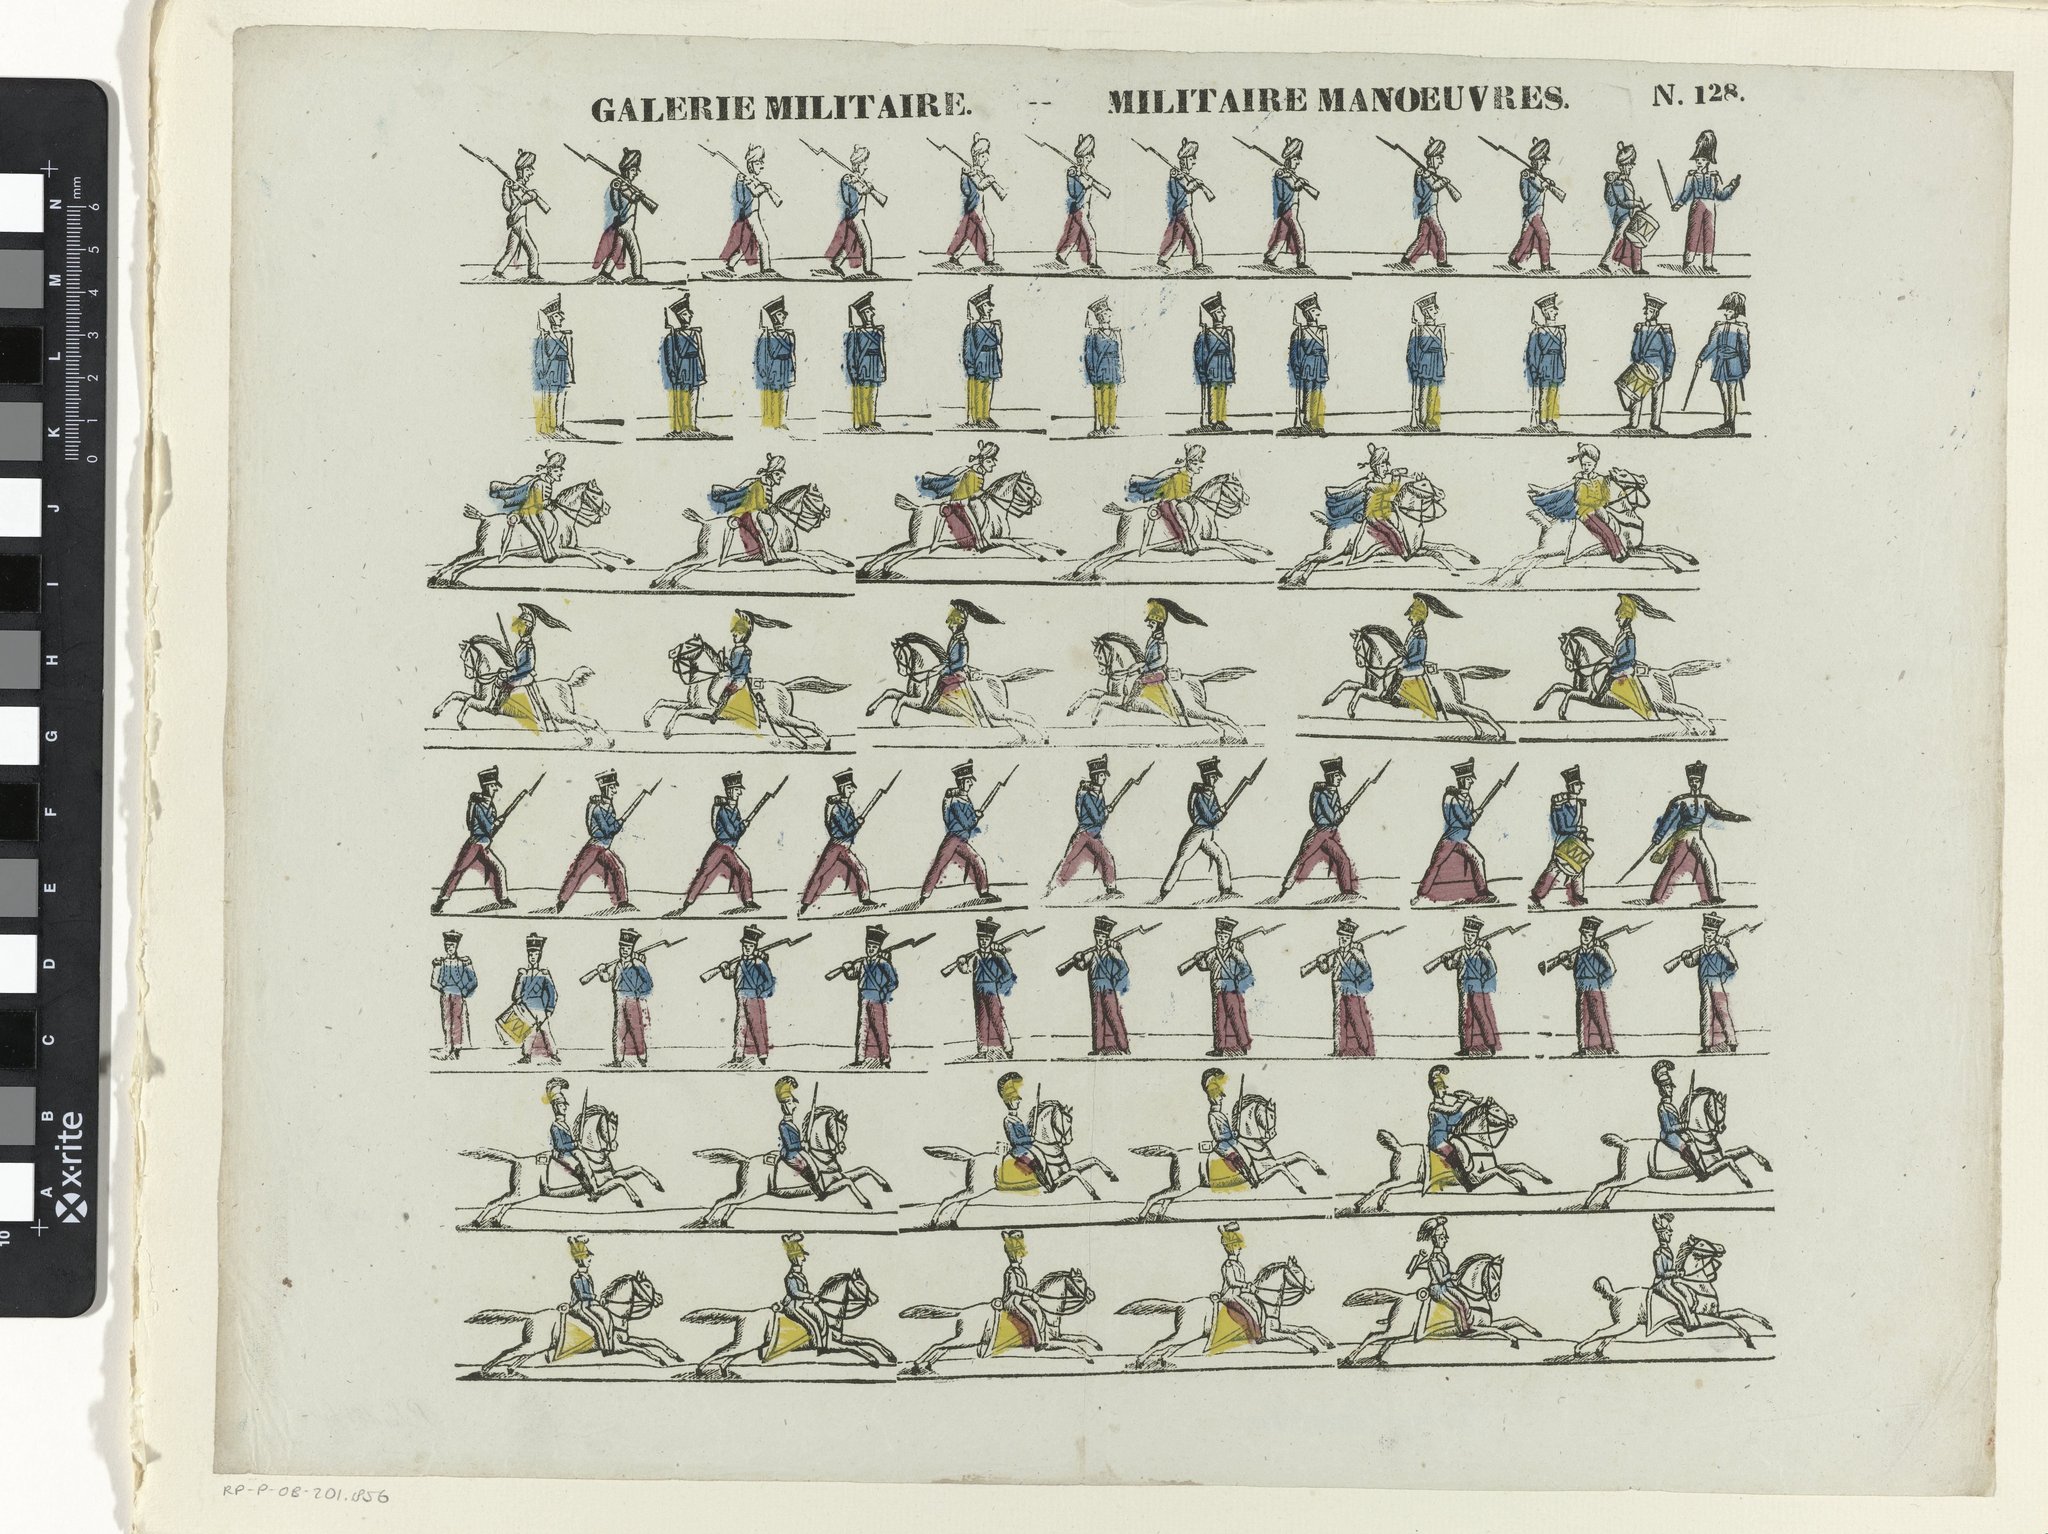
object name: popular print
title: Galerie militaire / Militaire manoeuvres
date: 1800-1833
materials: paper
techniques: colour, letterpress printing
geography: turnhout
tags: warfare; military affairs (+ cavalry, horsemen), the soldier; the soldier's life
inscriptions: collector's mark: Lugt 2760, inscription: ‘P. Leidekker’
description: Blad met 8 horizontale rijen met voorstellingen van militairen met wapens en militairen te paard. Genummerd rechtsboven: N. 128.